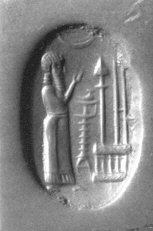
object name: stamp seal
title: Stamp seal (oval conoid, pin preserved) with cultic scene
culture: assyro-babylonian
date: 734-501 BCE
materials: stone, bronze, copper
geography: mesopotamia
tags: men